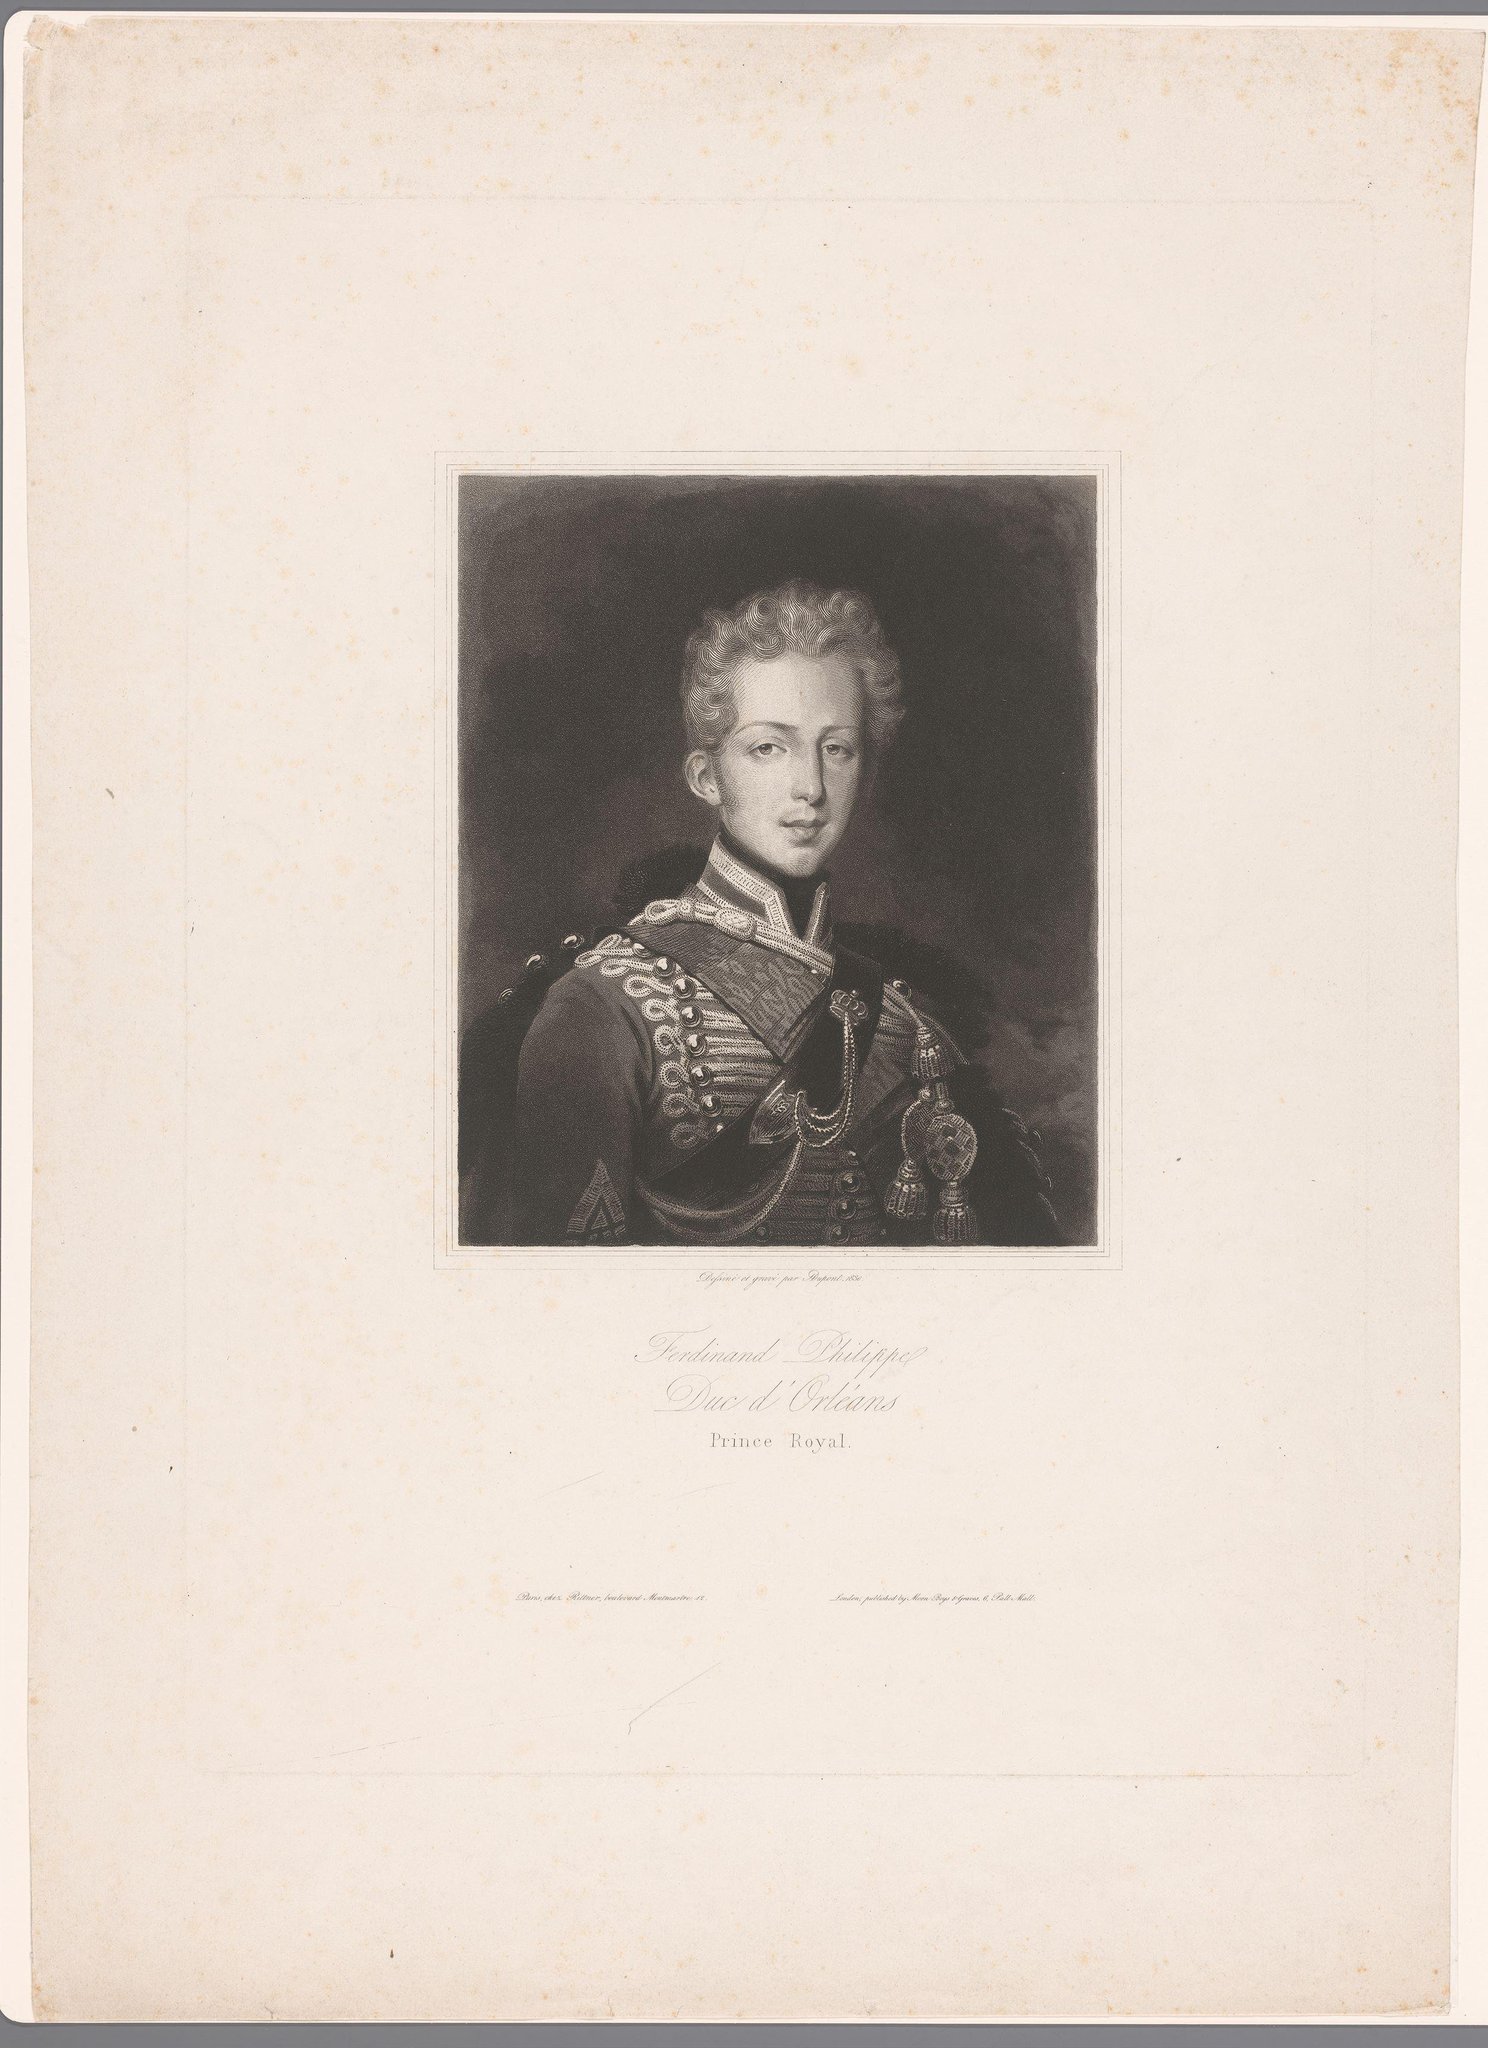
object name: print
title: Portret van Ferdinand-Philippe, hertog van Orleans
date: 1830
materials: paper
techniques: aquatint, etching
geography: london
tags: prince, historical persons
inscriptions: collector's mark: Lugt 2228, check stamp: Lugt 1202